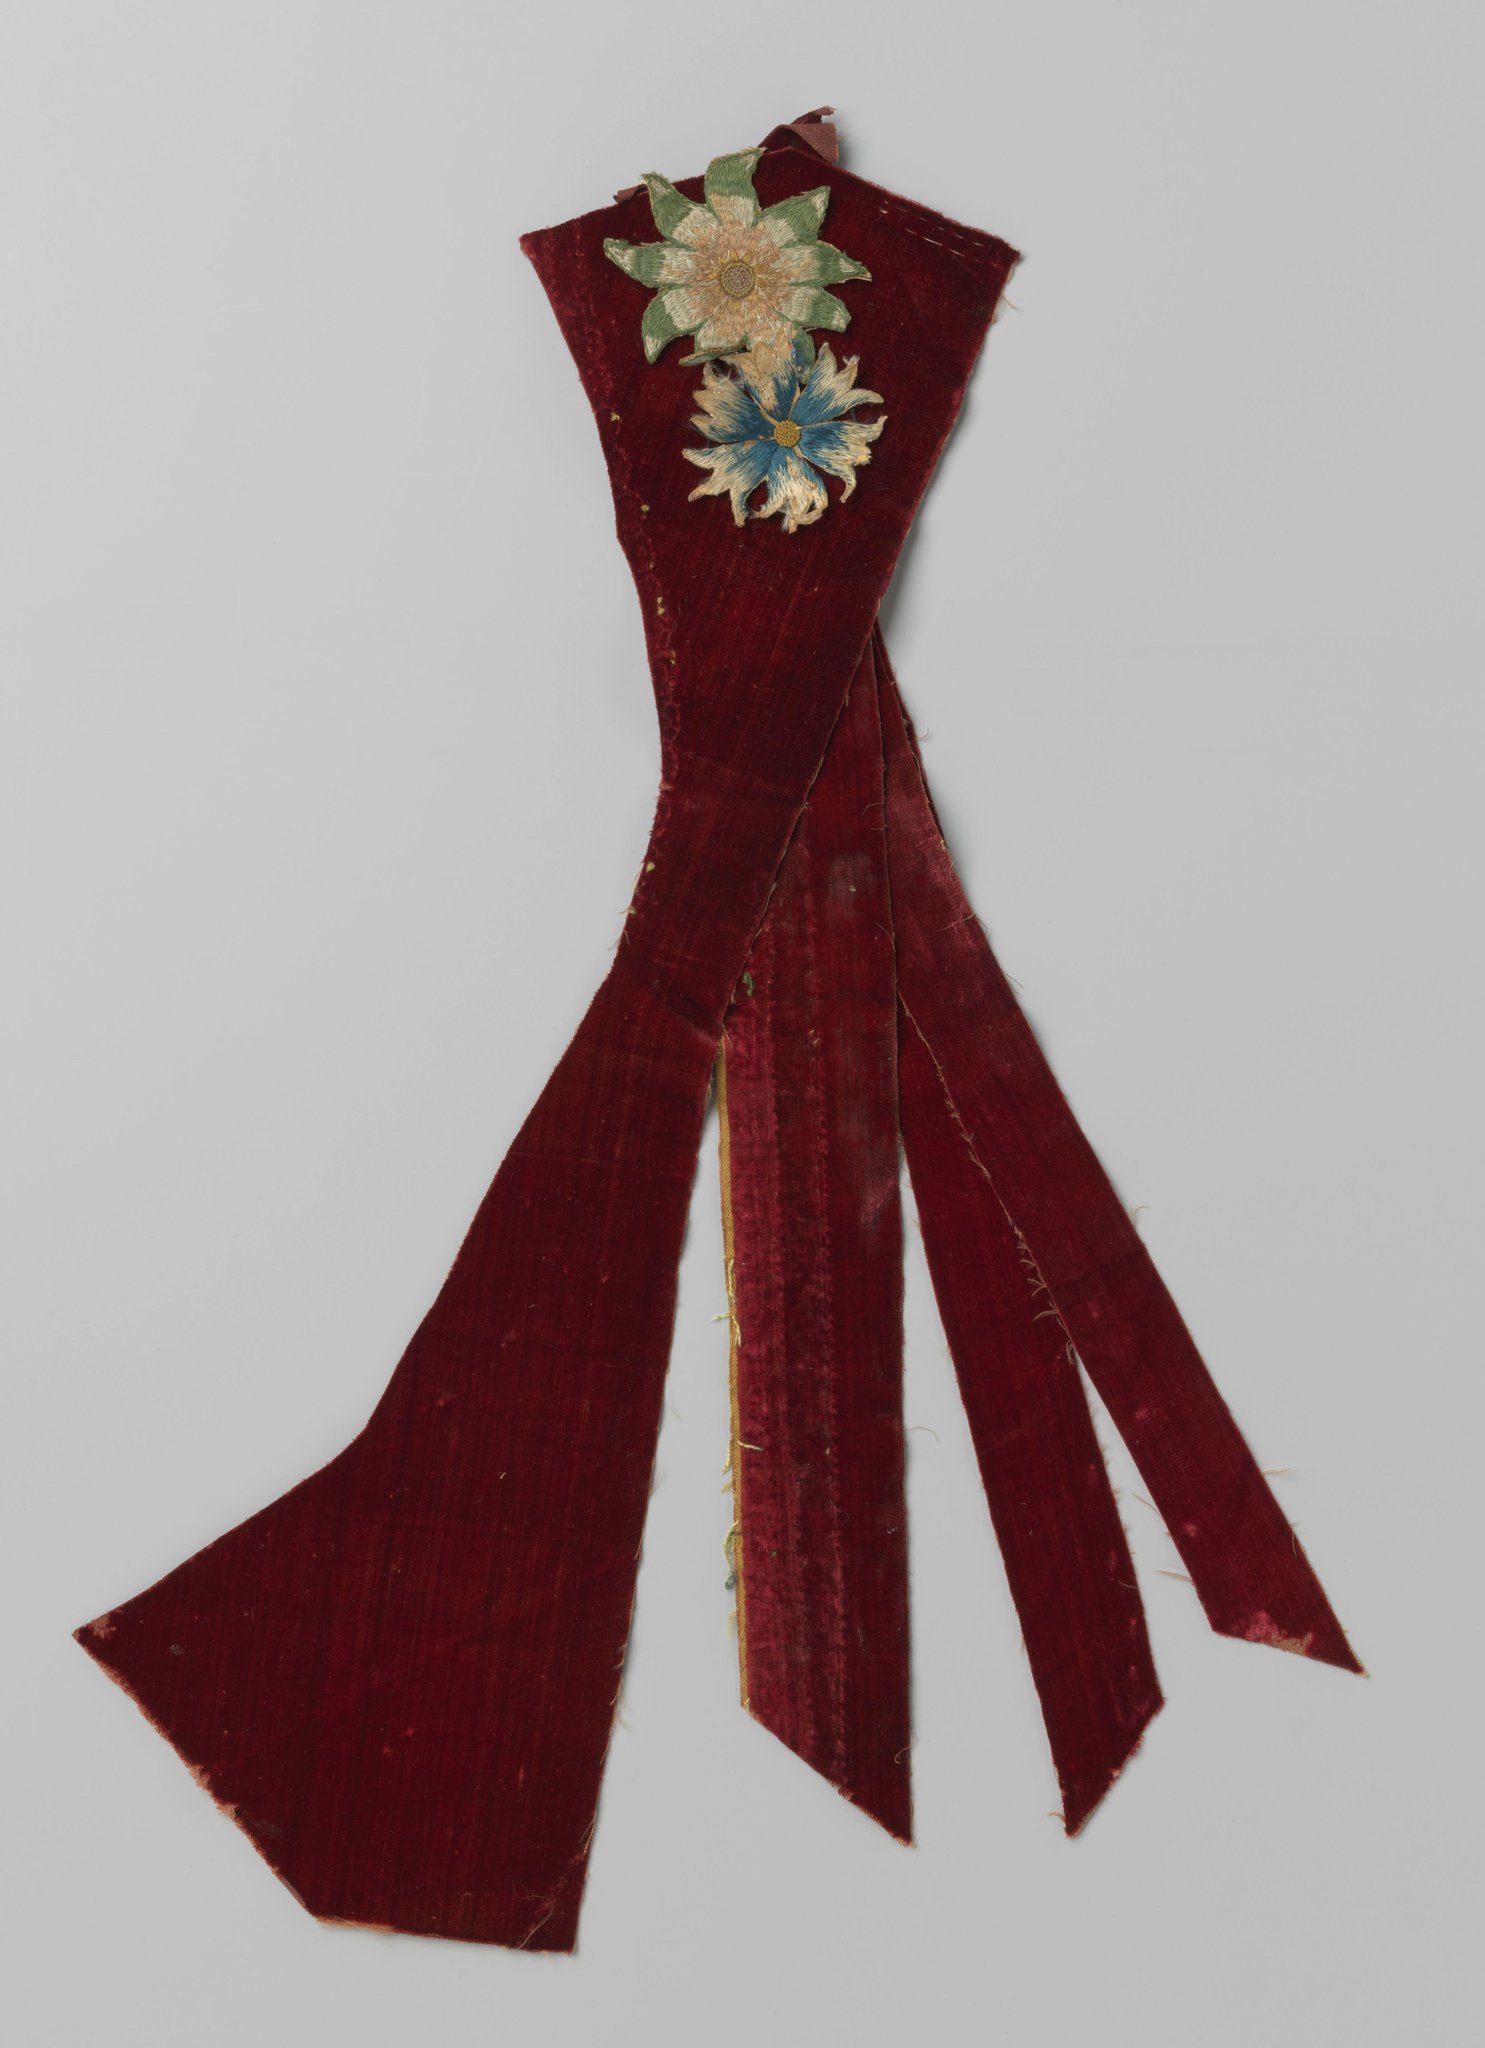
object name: embroidery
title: Vier fragmenten rood fluweel met twee geborduurde bloemen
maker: Anonymous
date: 1400-1950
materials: silk, velvet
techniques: embroidered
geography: europe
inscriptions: label: ‘NM.9808’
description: Vier fragmenten langwerpige rode zijdefluweel met sporen van naaiwerk. De fragmenten zijn over elkaar vastgezet met twee geborduurde bloemen. De grootste bloem heeft negen blaadjes, aan de uiteinden zijn deze groen en deze gaan via wit naar een lichtroze. In het midden zit een geel met wit hart. De andere bloem heeft zes bloembladeren, deze zijn wit aan de uiteinden en blauw rond het hart, het hart is geel. Aan de achterkant van de fragmenten bevinden zich restanten van lijm(?).